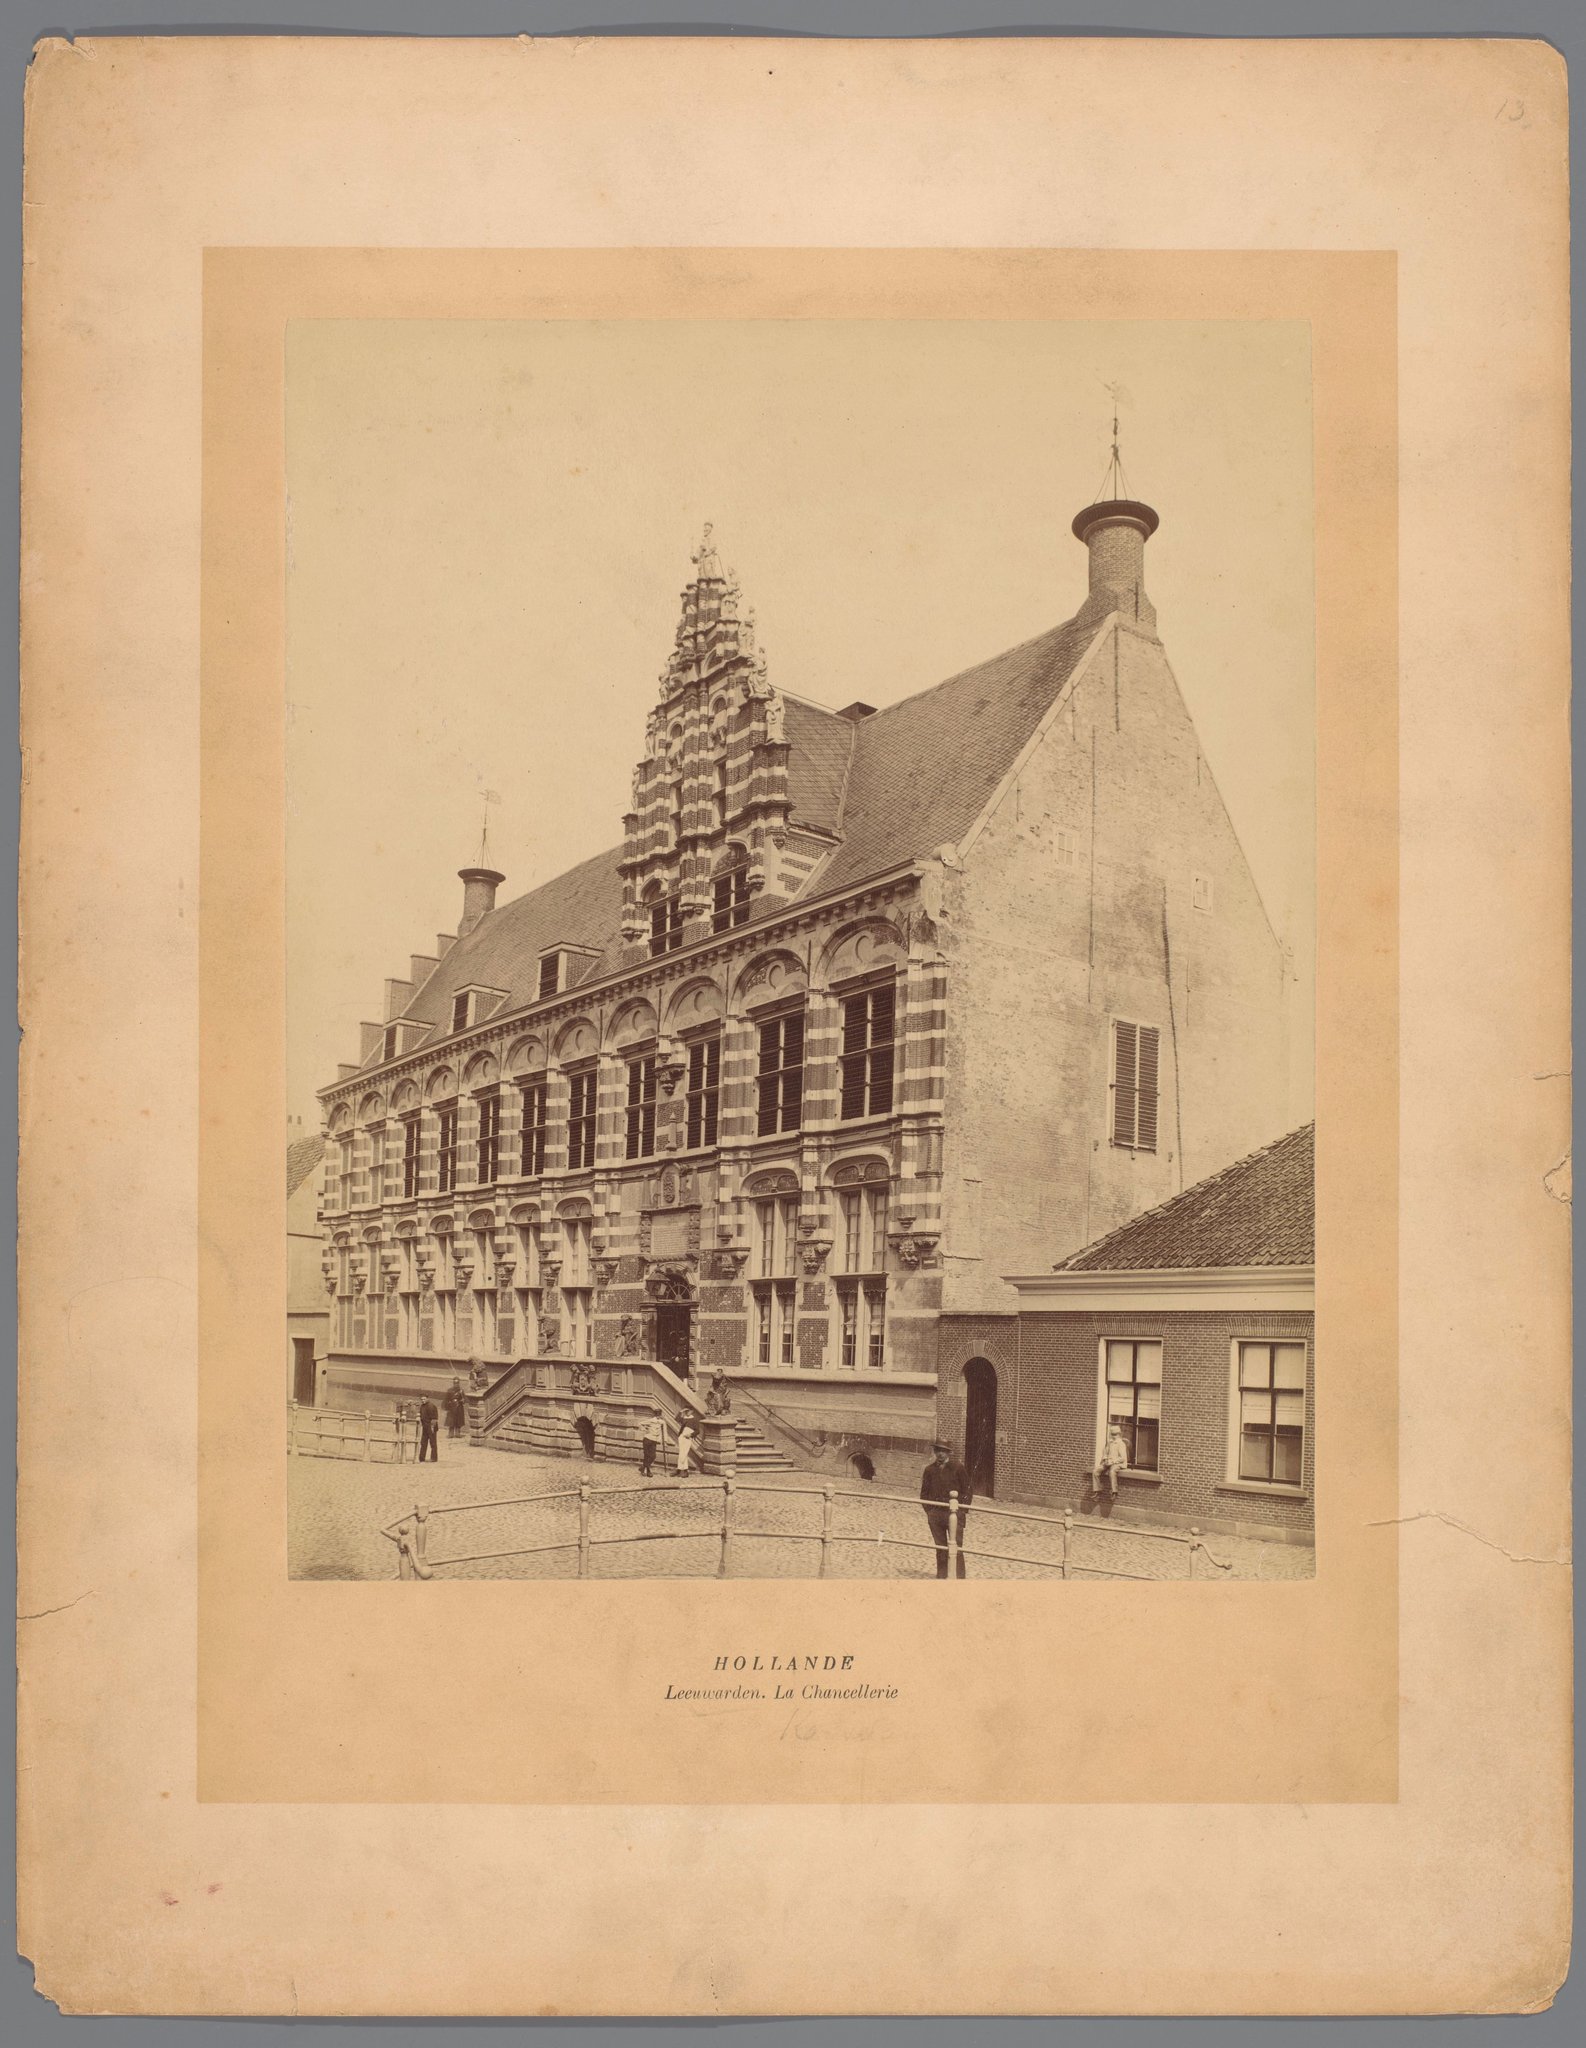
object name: photograph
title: Exterieur van de kanselarij te Leeuwarden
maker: Anonymous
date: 1875-1900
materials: cardboard, photographic support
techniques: albumen print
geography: leeuwarden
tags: registration bureau, civil registry, façade (of house or building)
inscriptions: collector's mark: Lugt 3937, inscription: ‘HOLLANDE Leeuwarden. La Chancellerie’